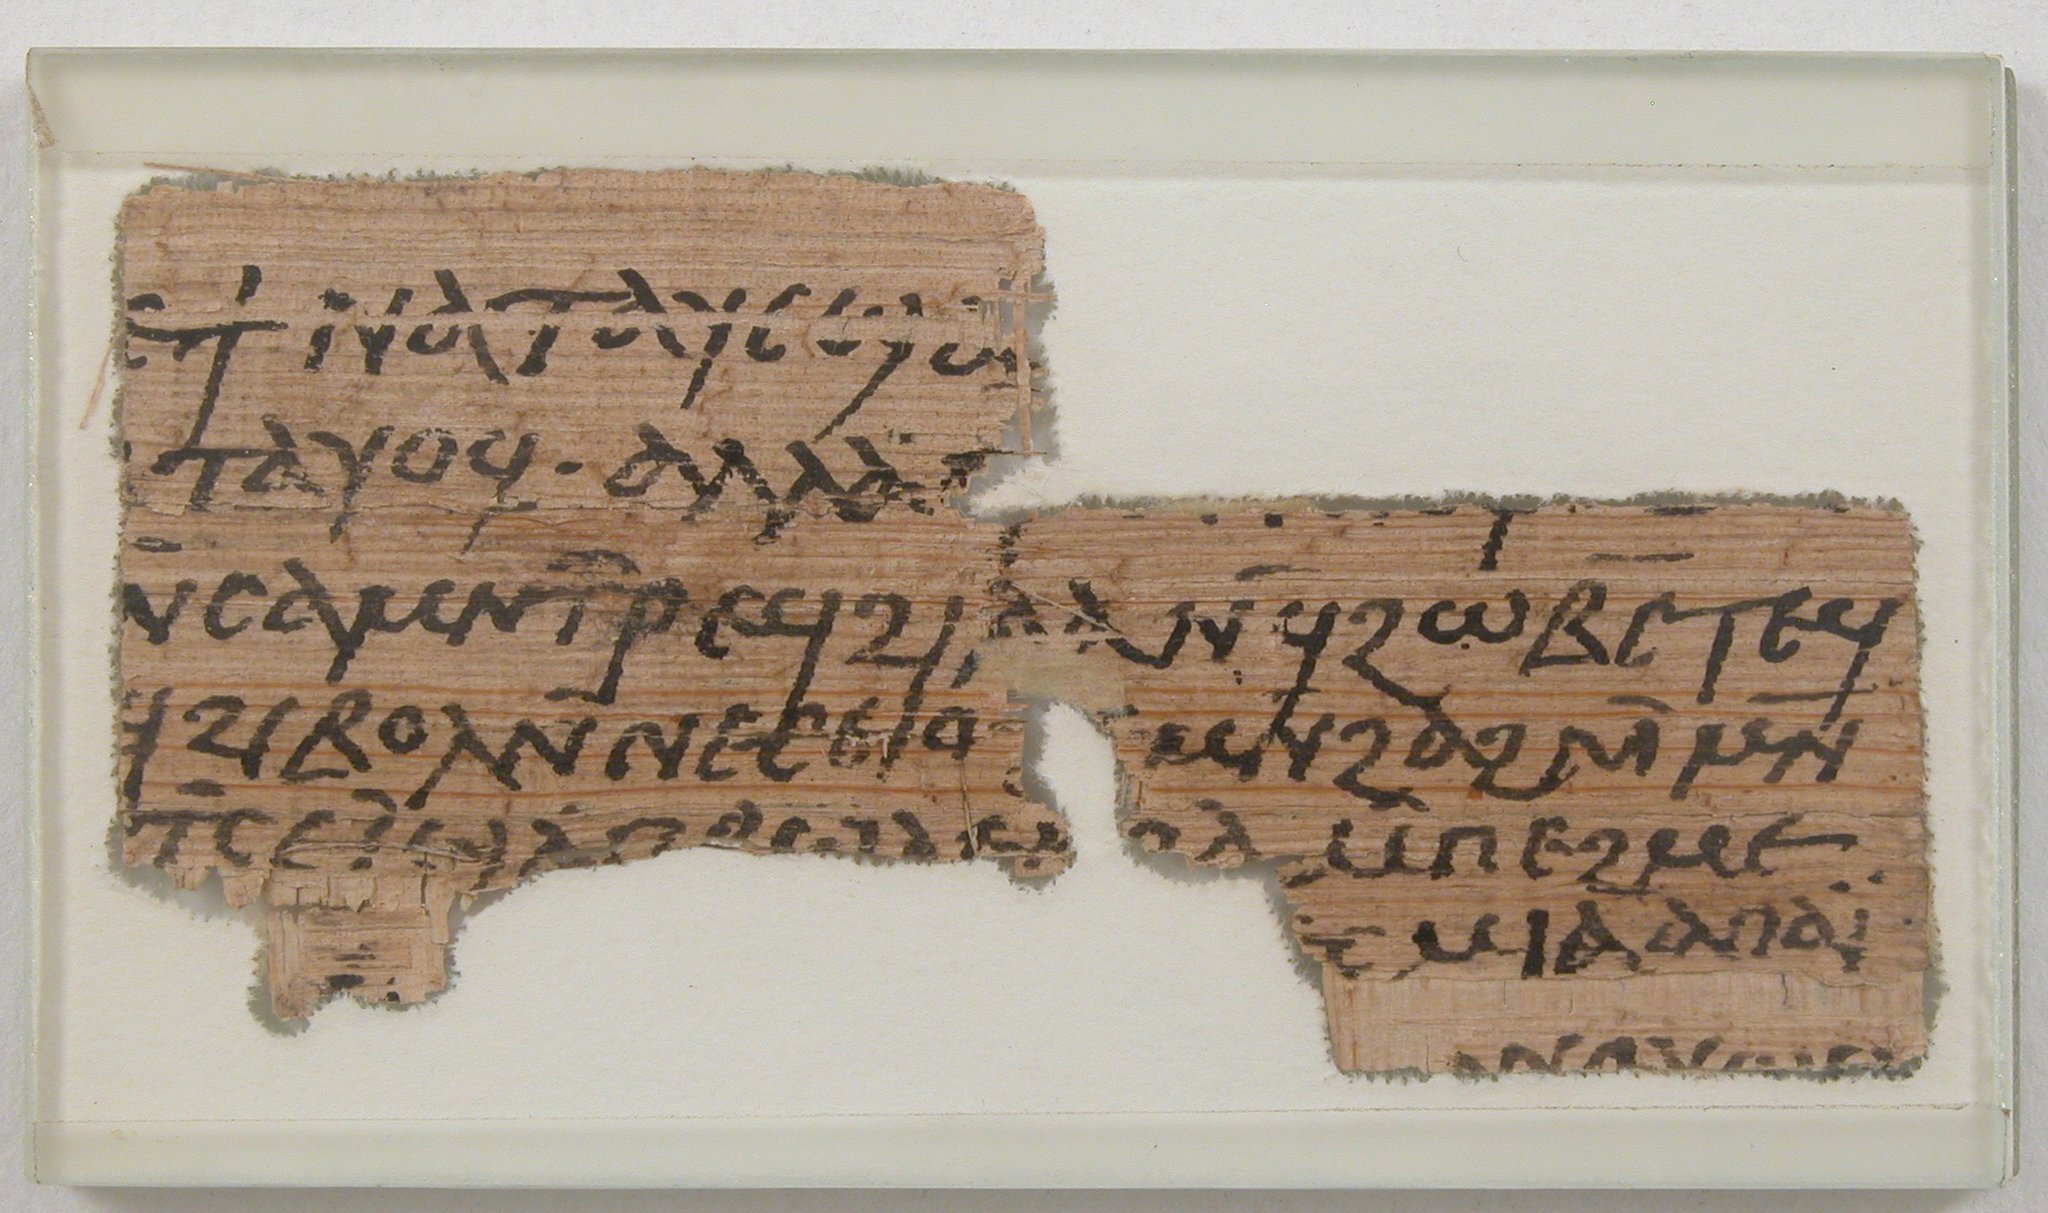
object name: fragment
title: Papyrus Fragment of Two Letters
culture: coptic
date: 580-640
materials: ink, papyrus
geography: egypt